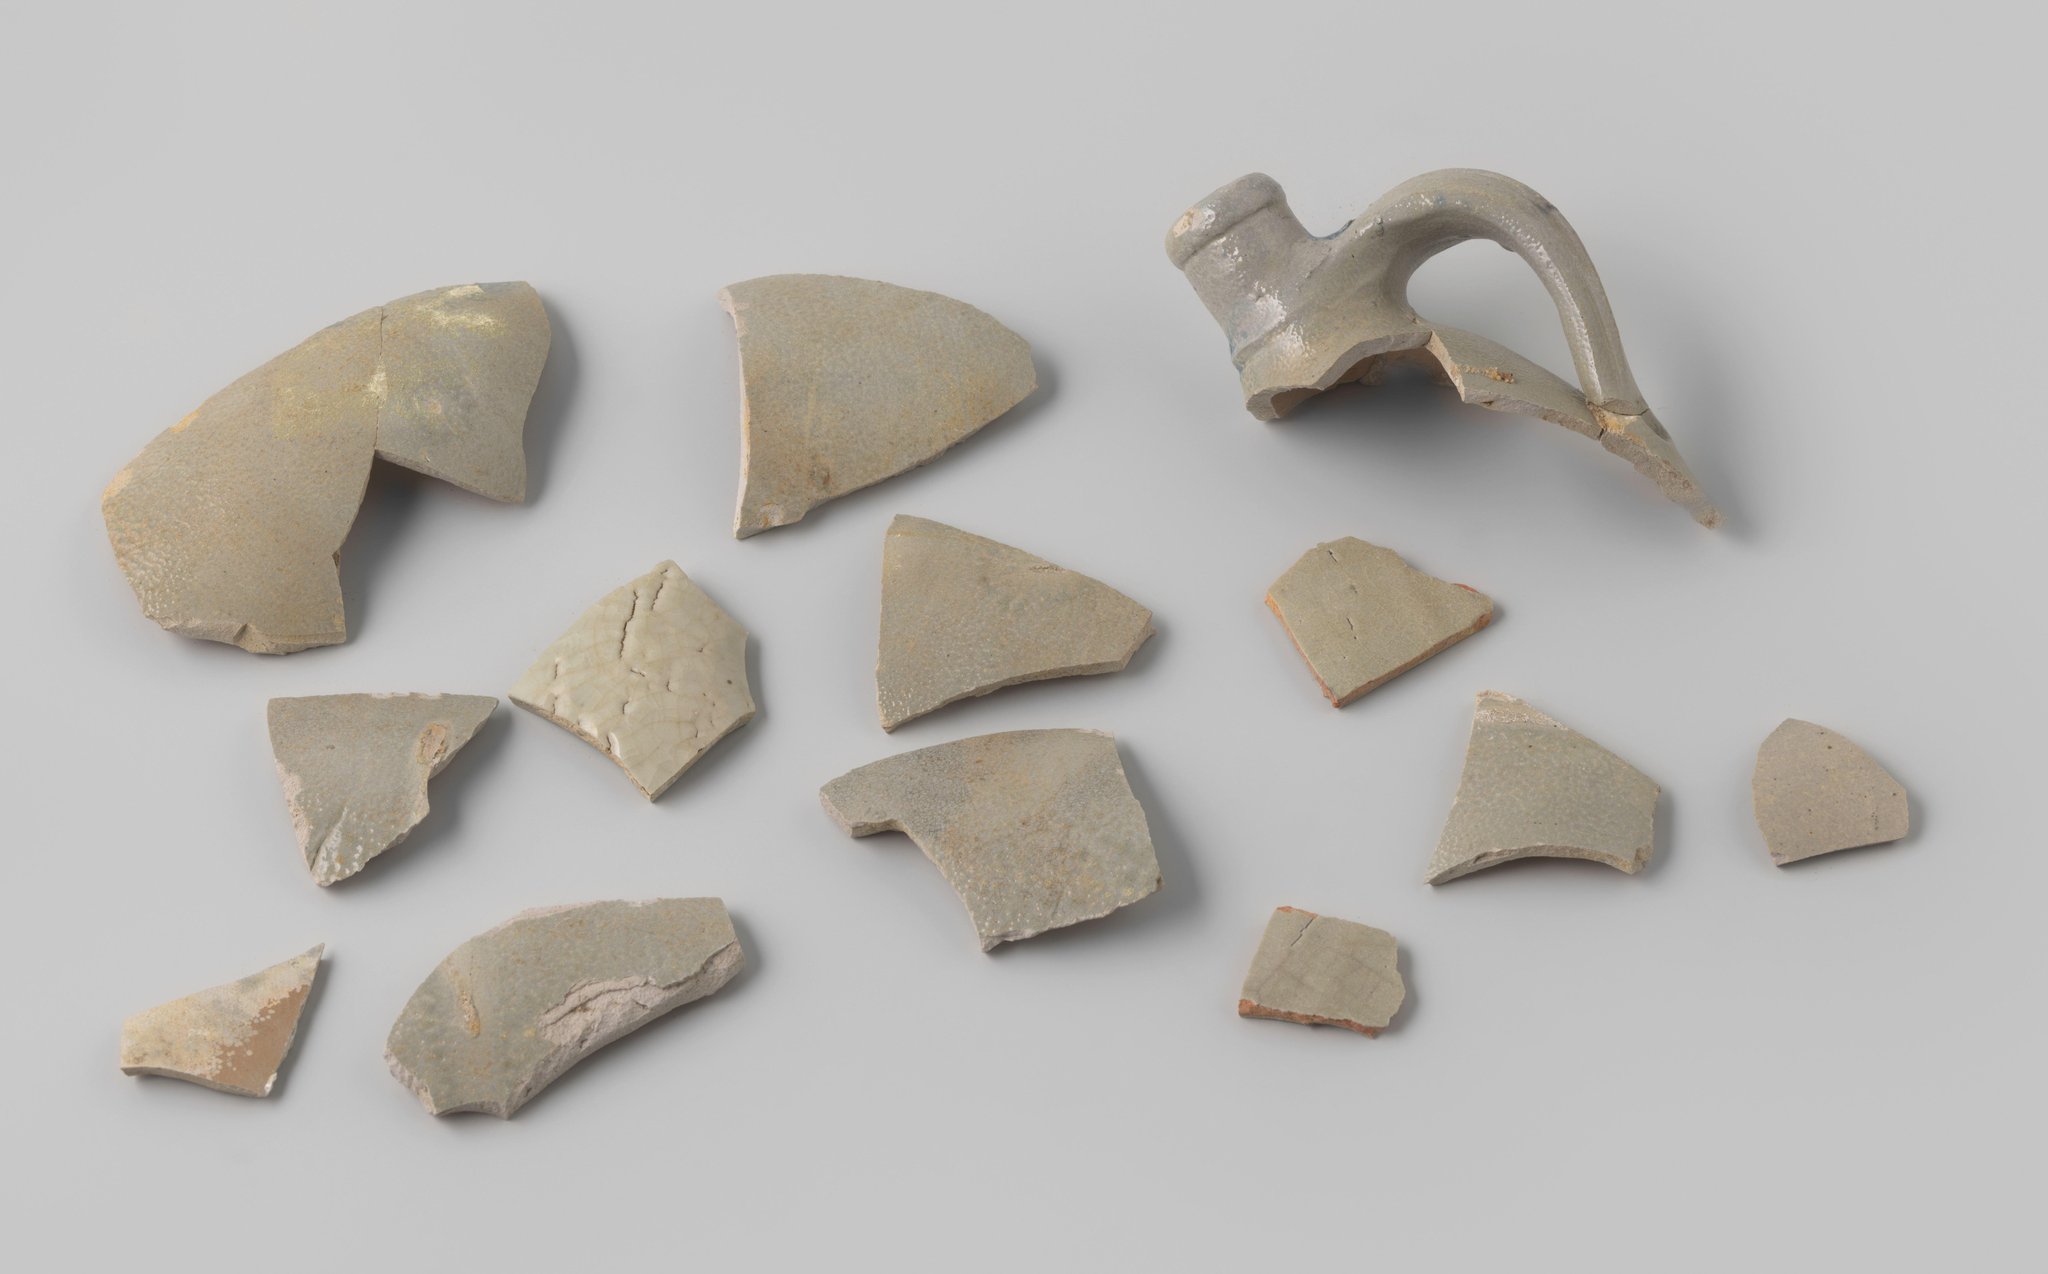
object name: sherd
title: Dertien scherven steengoed van verschillende objecten uit V.O.C.-schip de 'Witte Leeuw'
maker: Anonymous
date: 1613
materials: earthenware, porcelain, stoneware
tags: verenigde oostindische compagnie, sint-helena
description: Dertien scherven steengoed van verschillende objecten uit V.O.C.-schip de 'Witte Leeuw'.